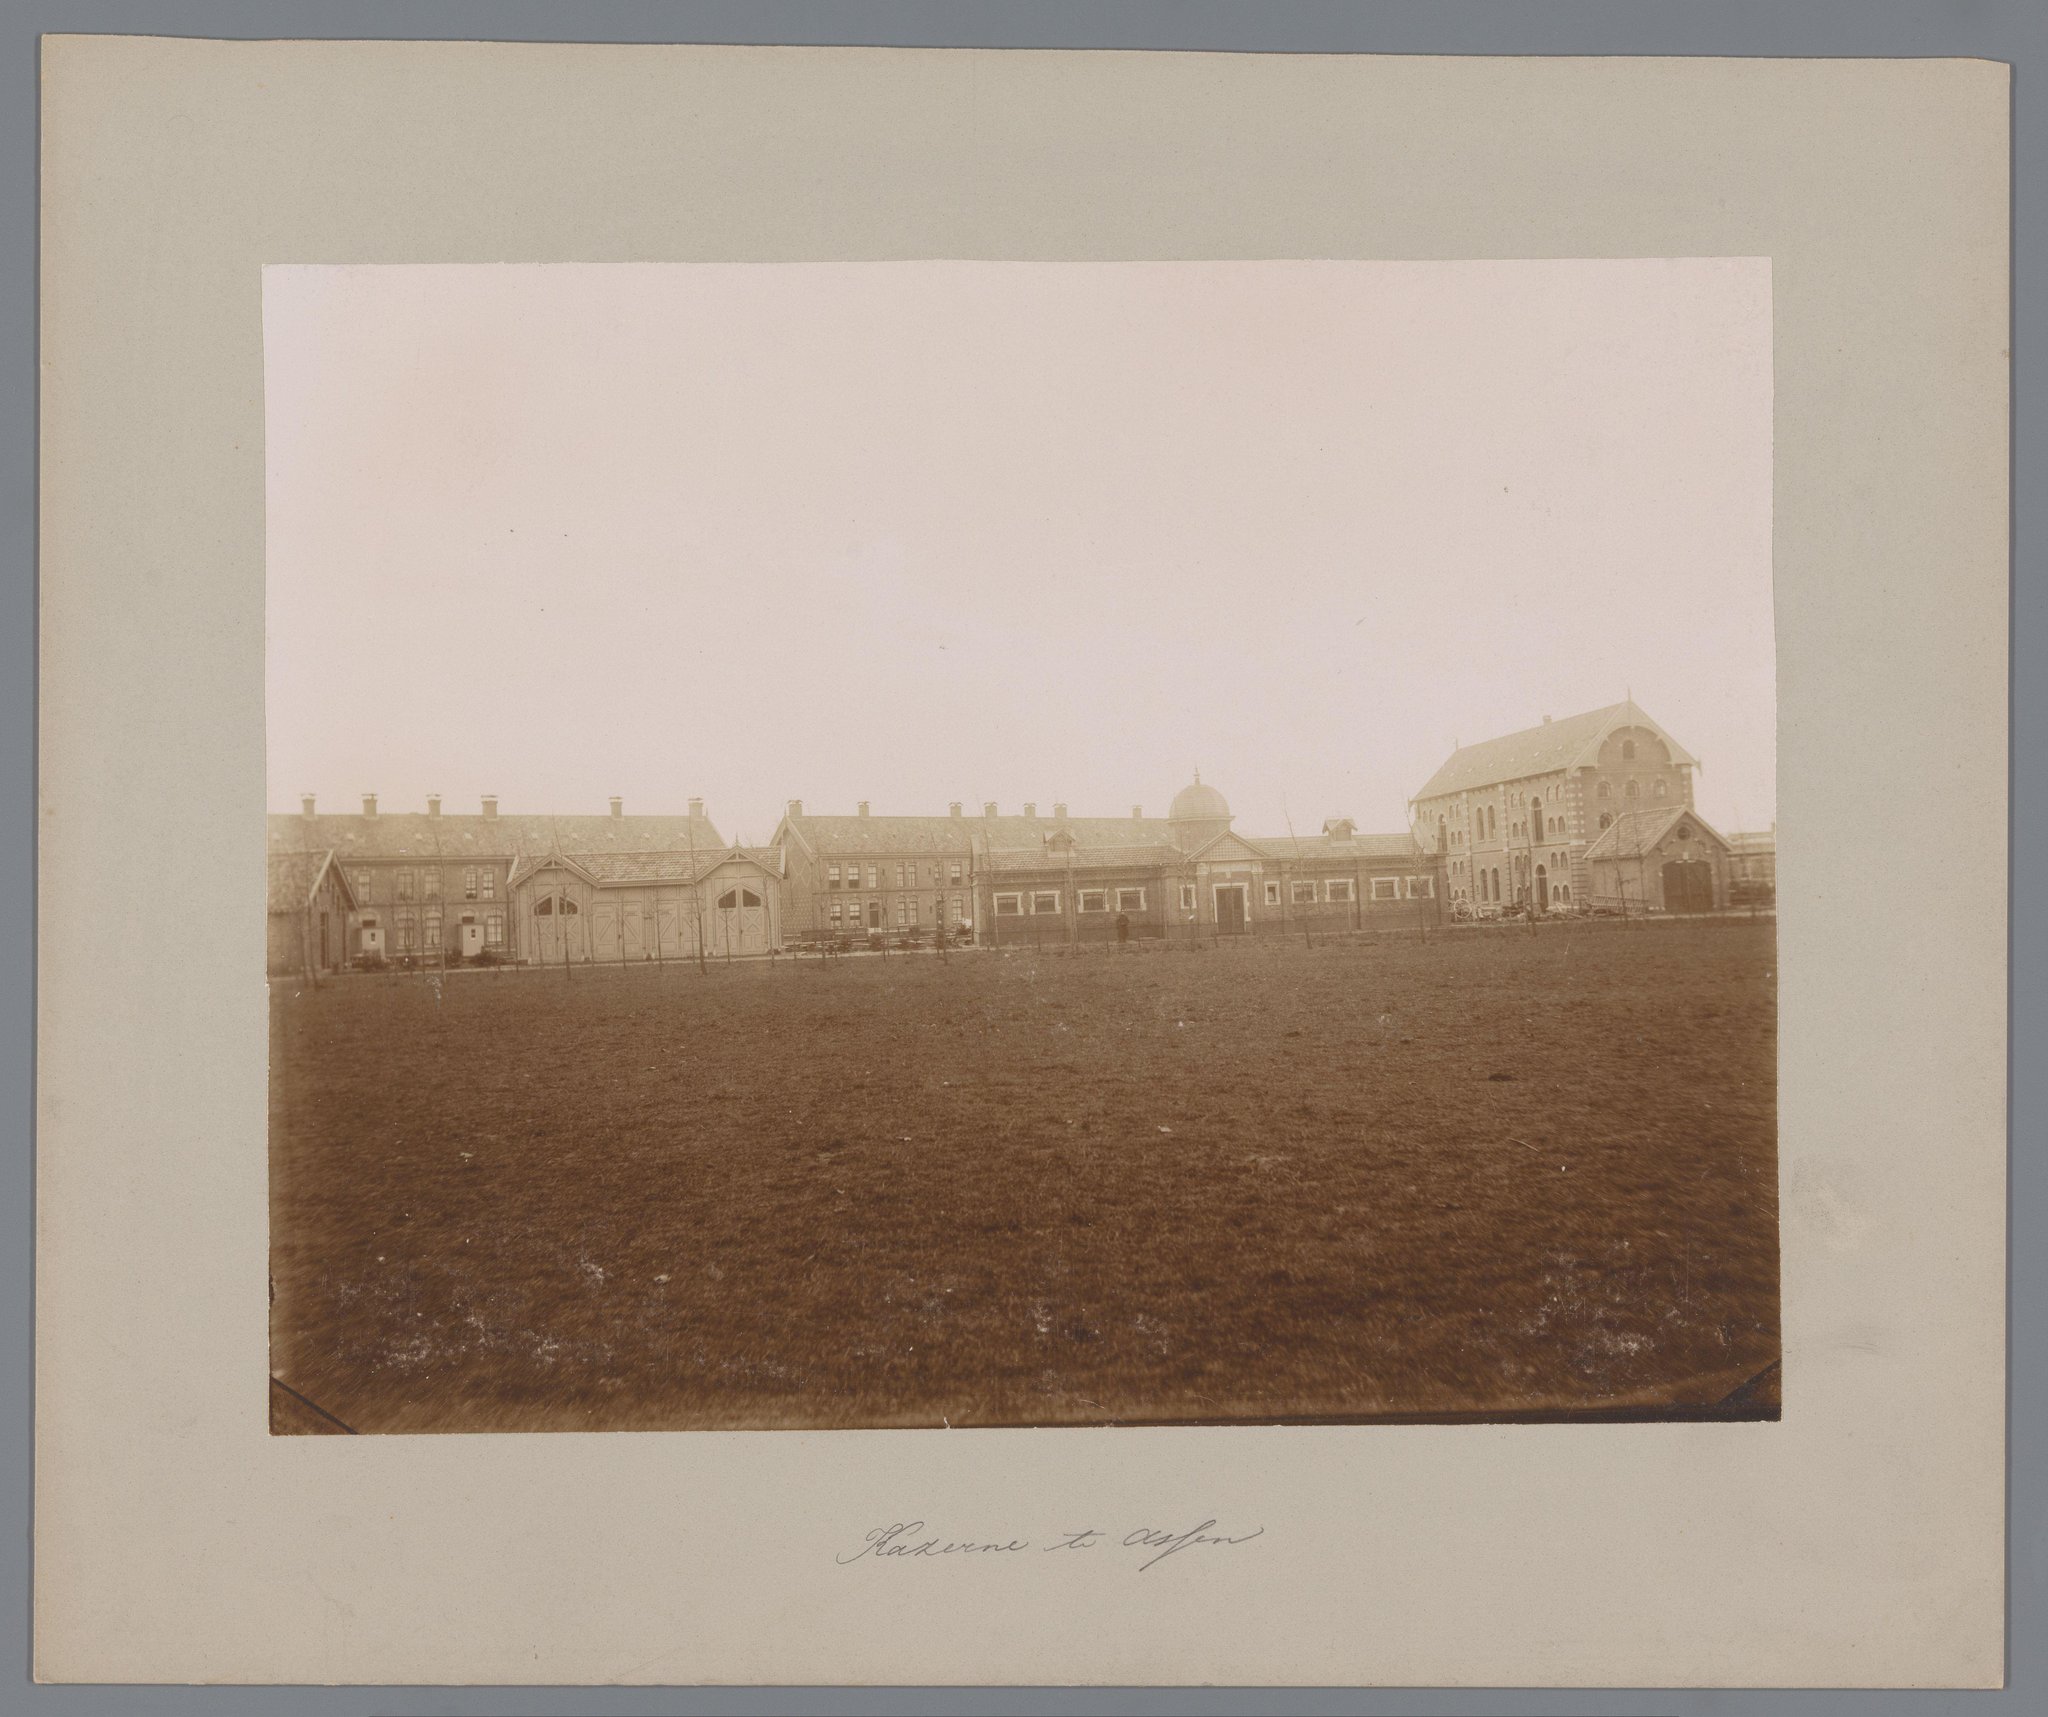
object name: photograph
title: Terrein van de Johan Willem Frisokazerne te Assen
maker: Anonymous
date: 1892-1920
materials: cardboard, photographic support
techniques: collodion silver print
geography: assen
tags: military academy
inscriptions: annotation: ‘Kazerne te Assen’